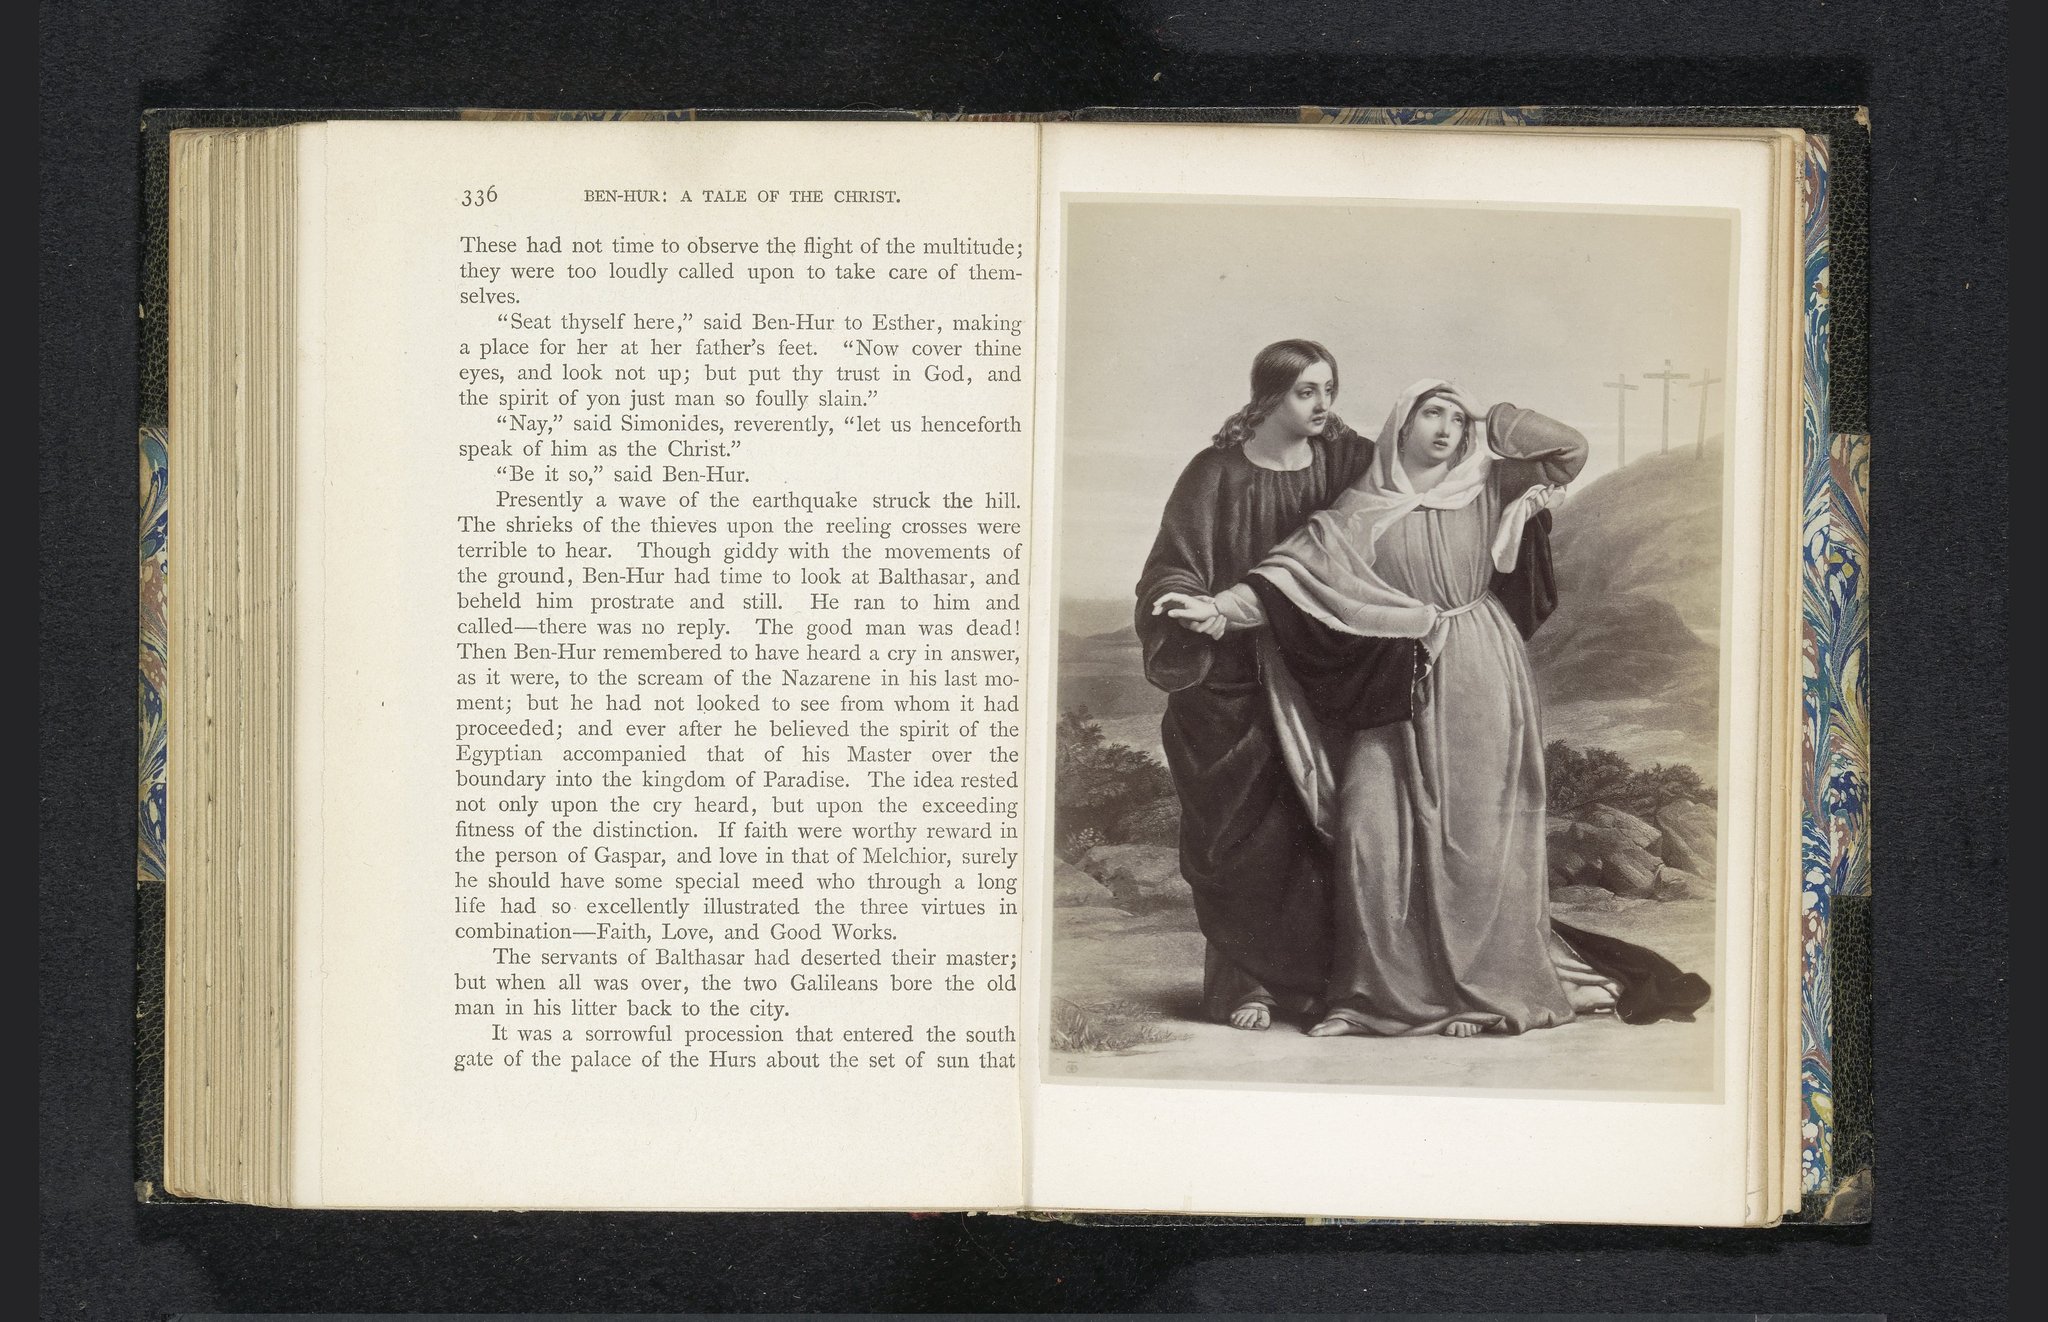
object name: page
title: Fotoreproductie van een schilderij, voorstellende Maria en de heilige Johannes na de kruisiging van Christus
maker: Anonymous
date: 1883-1888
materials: photographic support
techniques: albumen print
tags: (scenes from the life of) john the baptist and mary